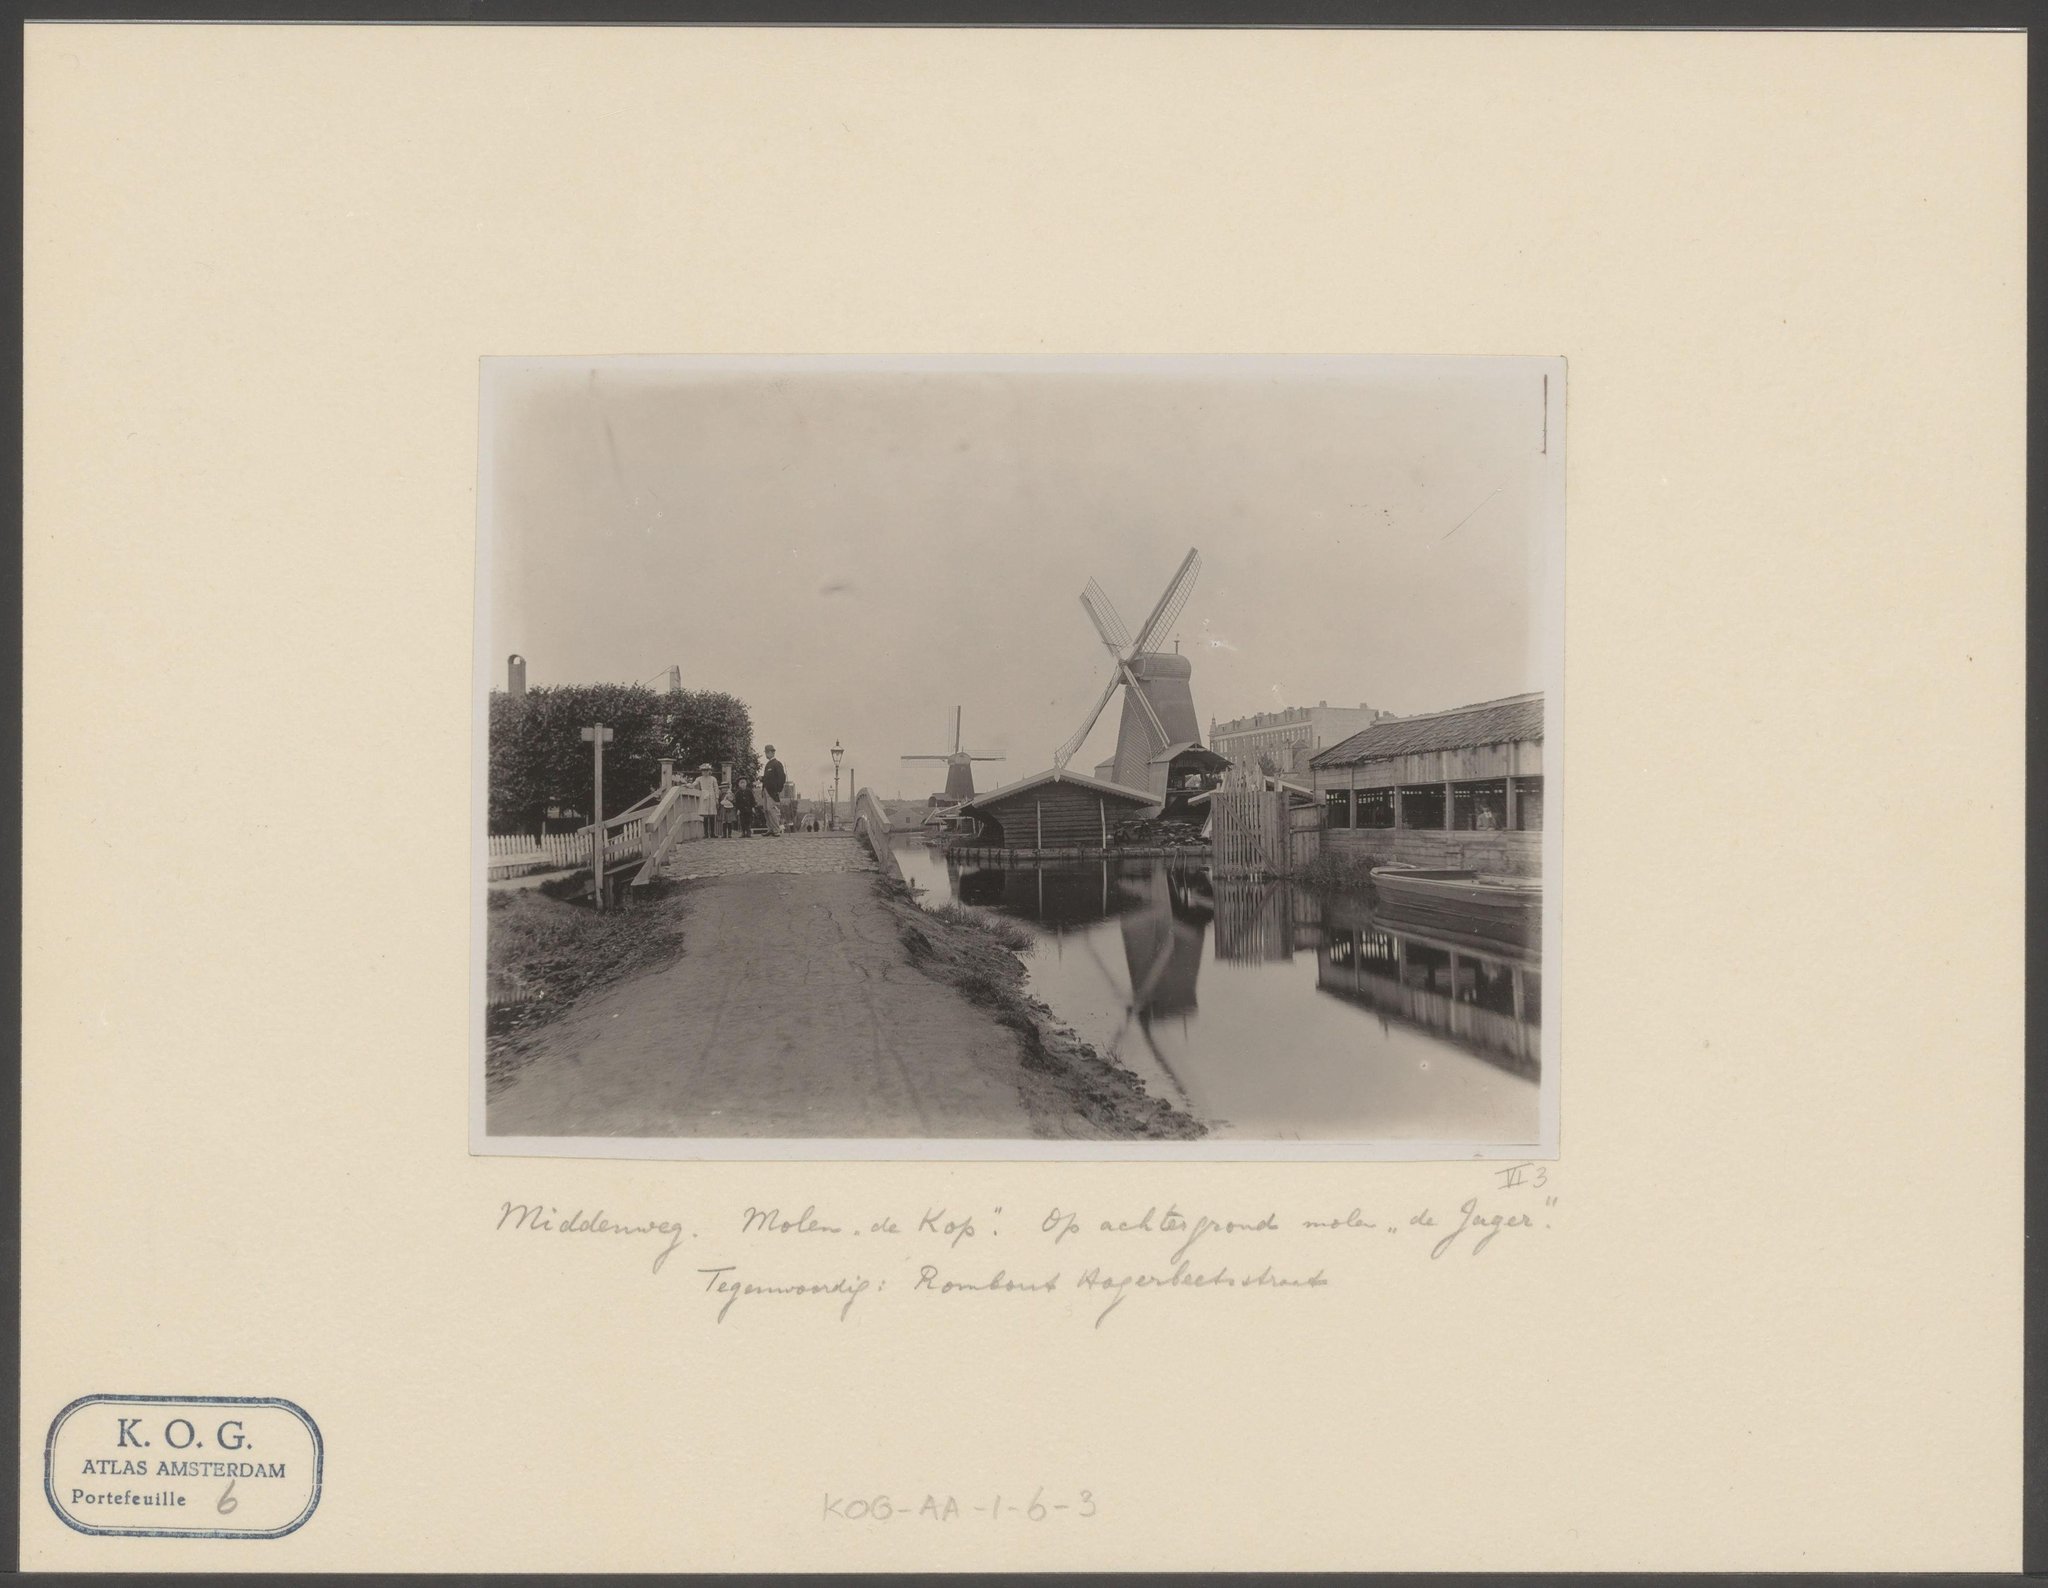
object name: photograph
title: Gezicht op molen De Kop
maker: Anonymous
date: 1875-1900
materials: paper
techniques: gelatin silver print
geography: amsterdam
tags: city-view in general; 'veduta', canal, road, path, windmill in landscape, bridge in city across river, canal, etc.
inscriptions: collector's mark: ‘6’ Lugt 1641b, inscription: ‘Middenweg. Molen "de Kop". Op achtergrond molen "de Jager". / Tegenwoordig: Rombaut Hogerbeetstraat’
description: Onderwerpsrubriek binnen de Atlas Amsterdam: Buitensingel of wel: Gezichten langs en op de Stadsvest van Haarlemmerpoort tot Raampoort.